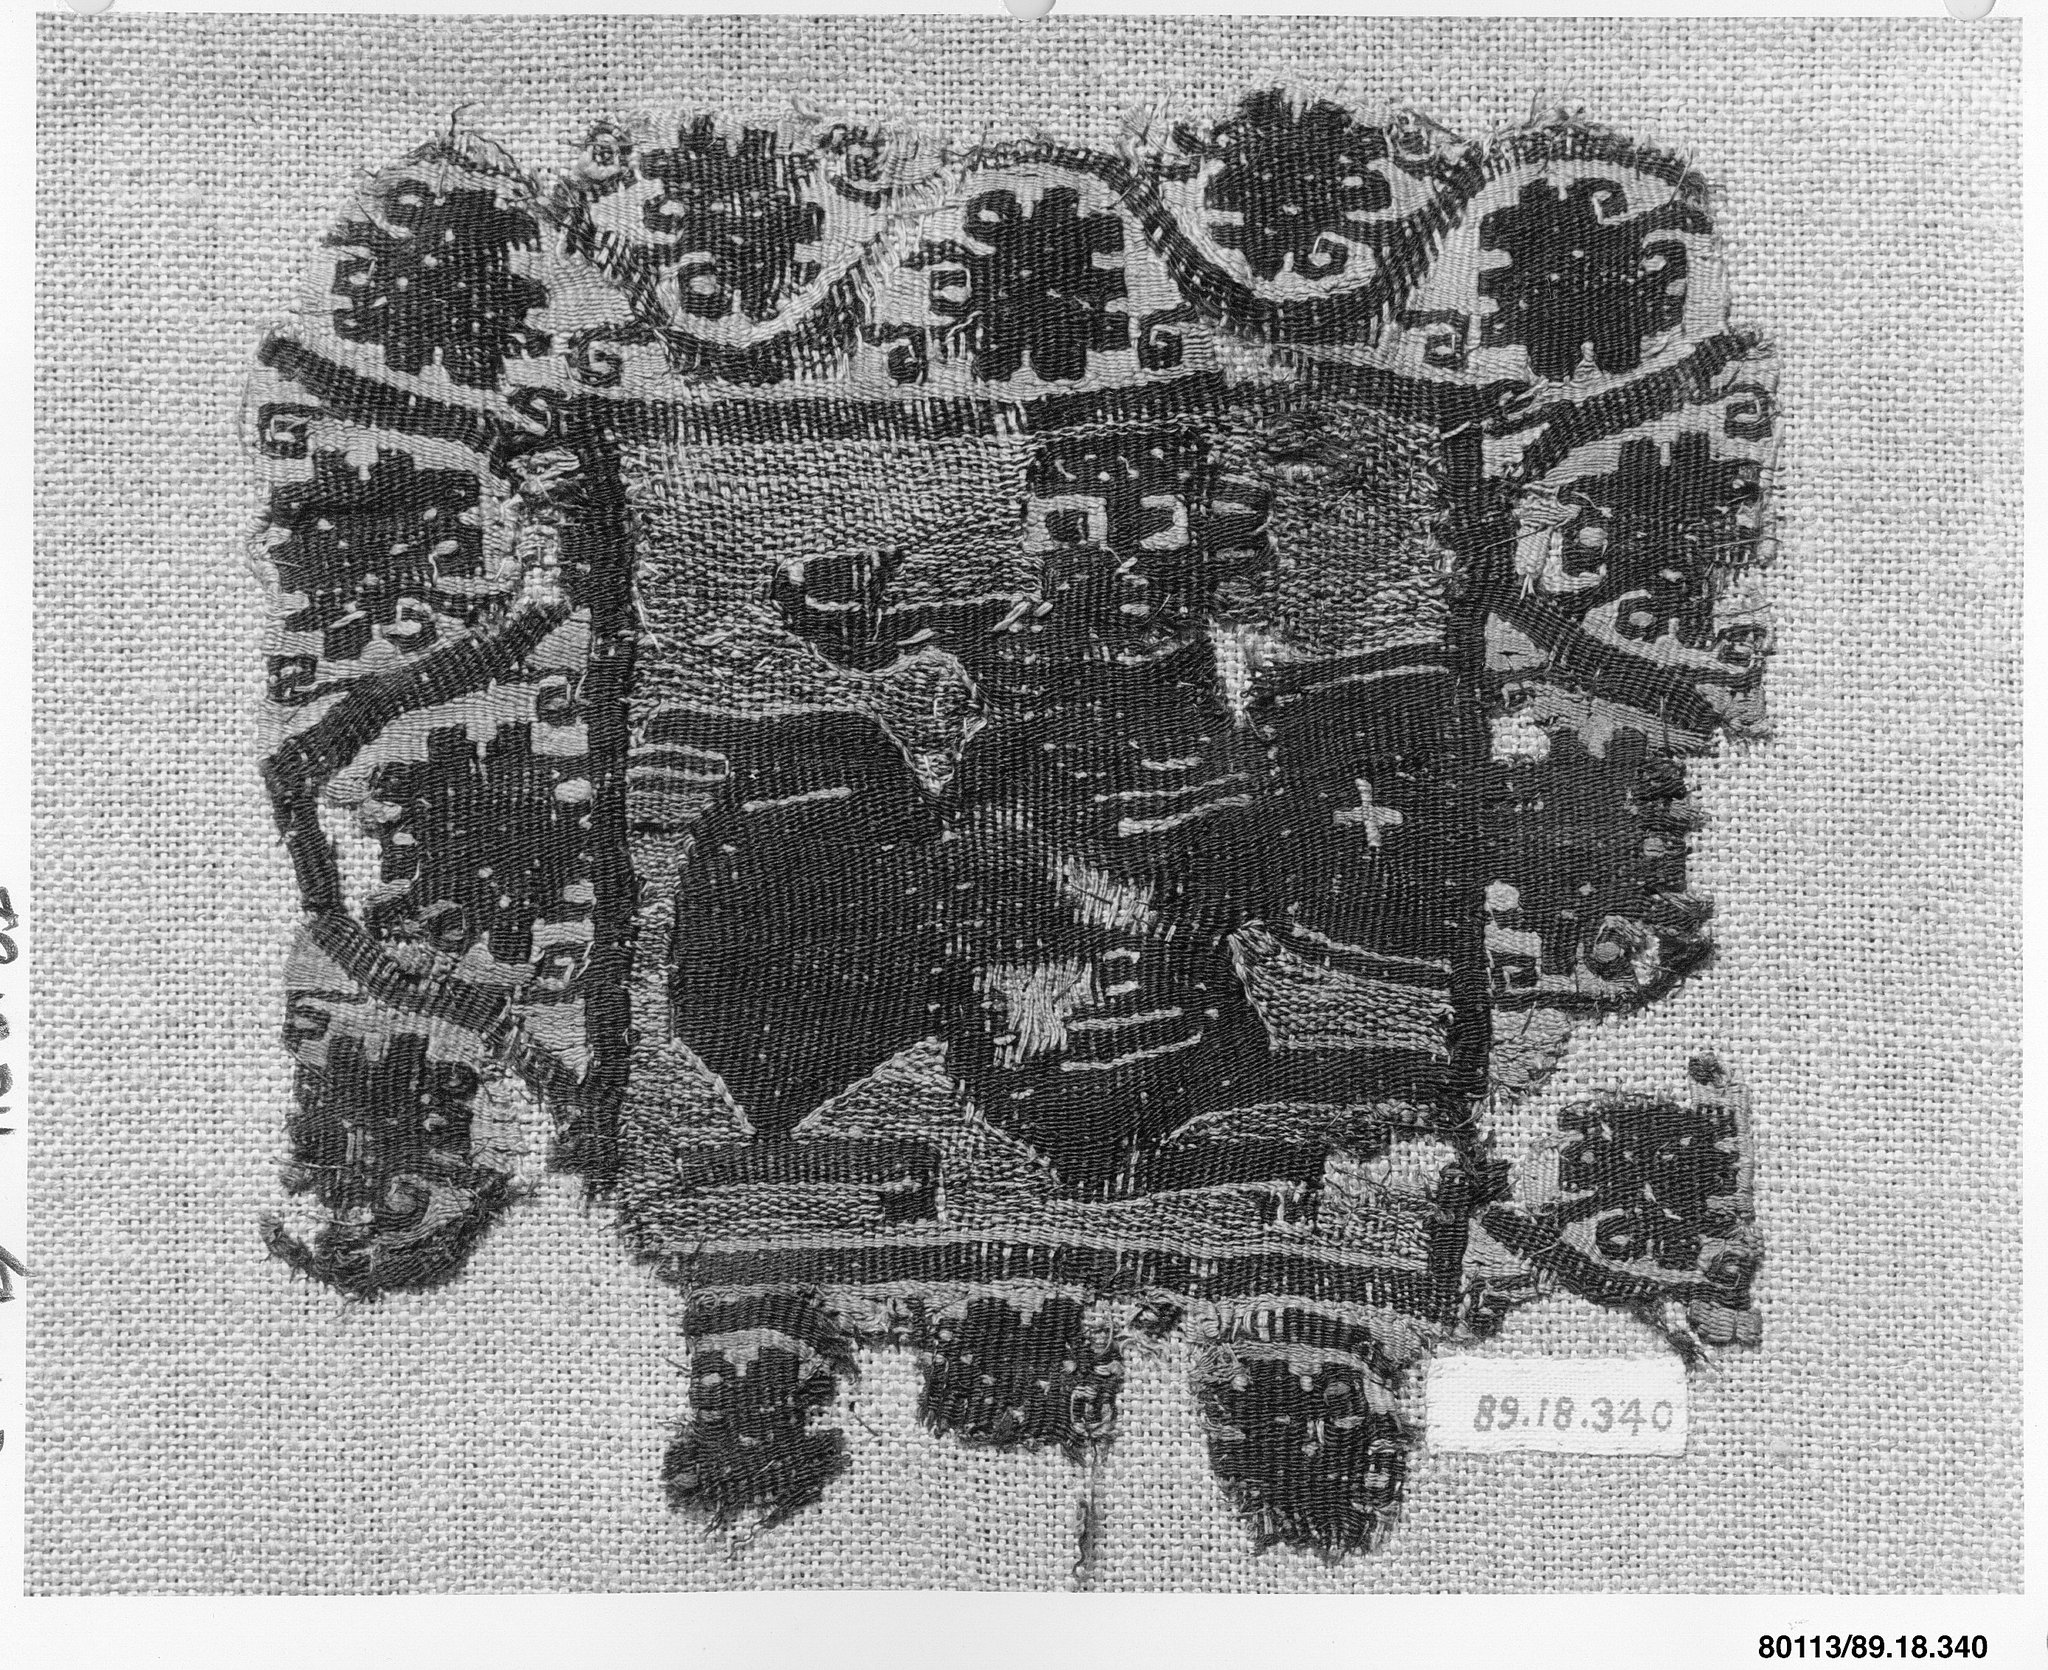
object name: textile fragment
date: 301-400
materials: linen, wool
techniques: weave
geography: egypt